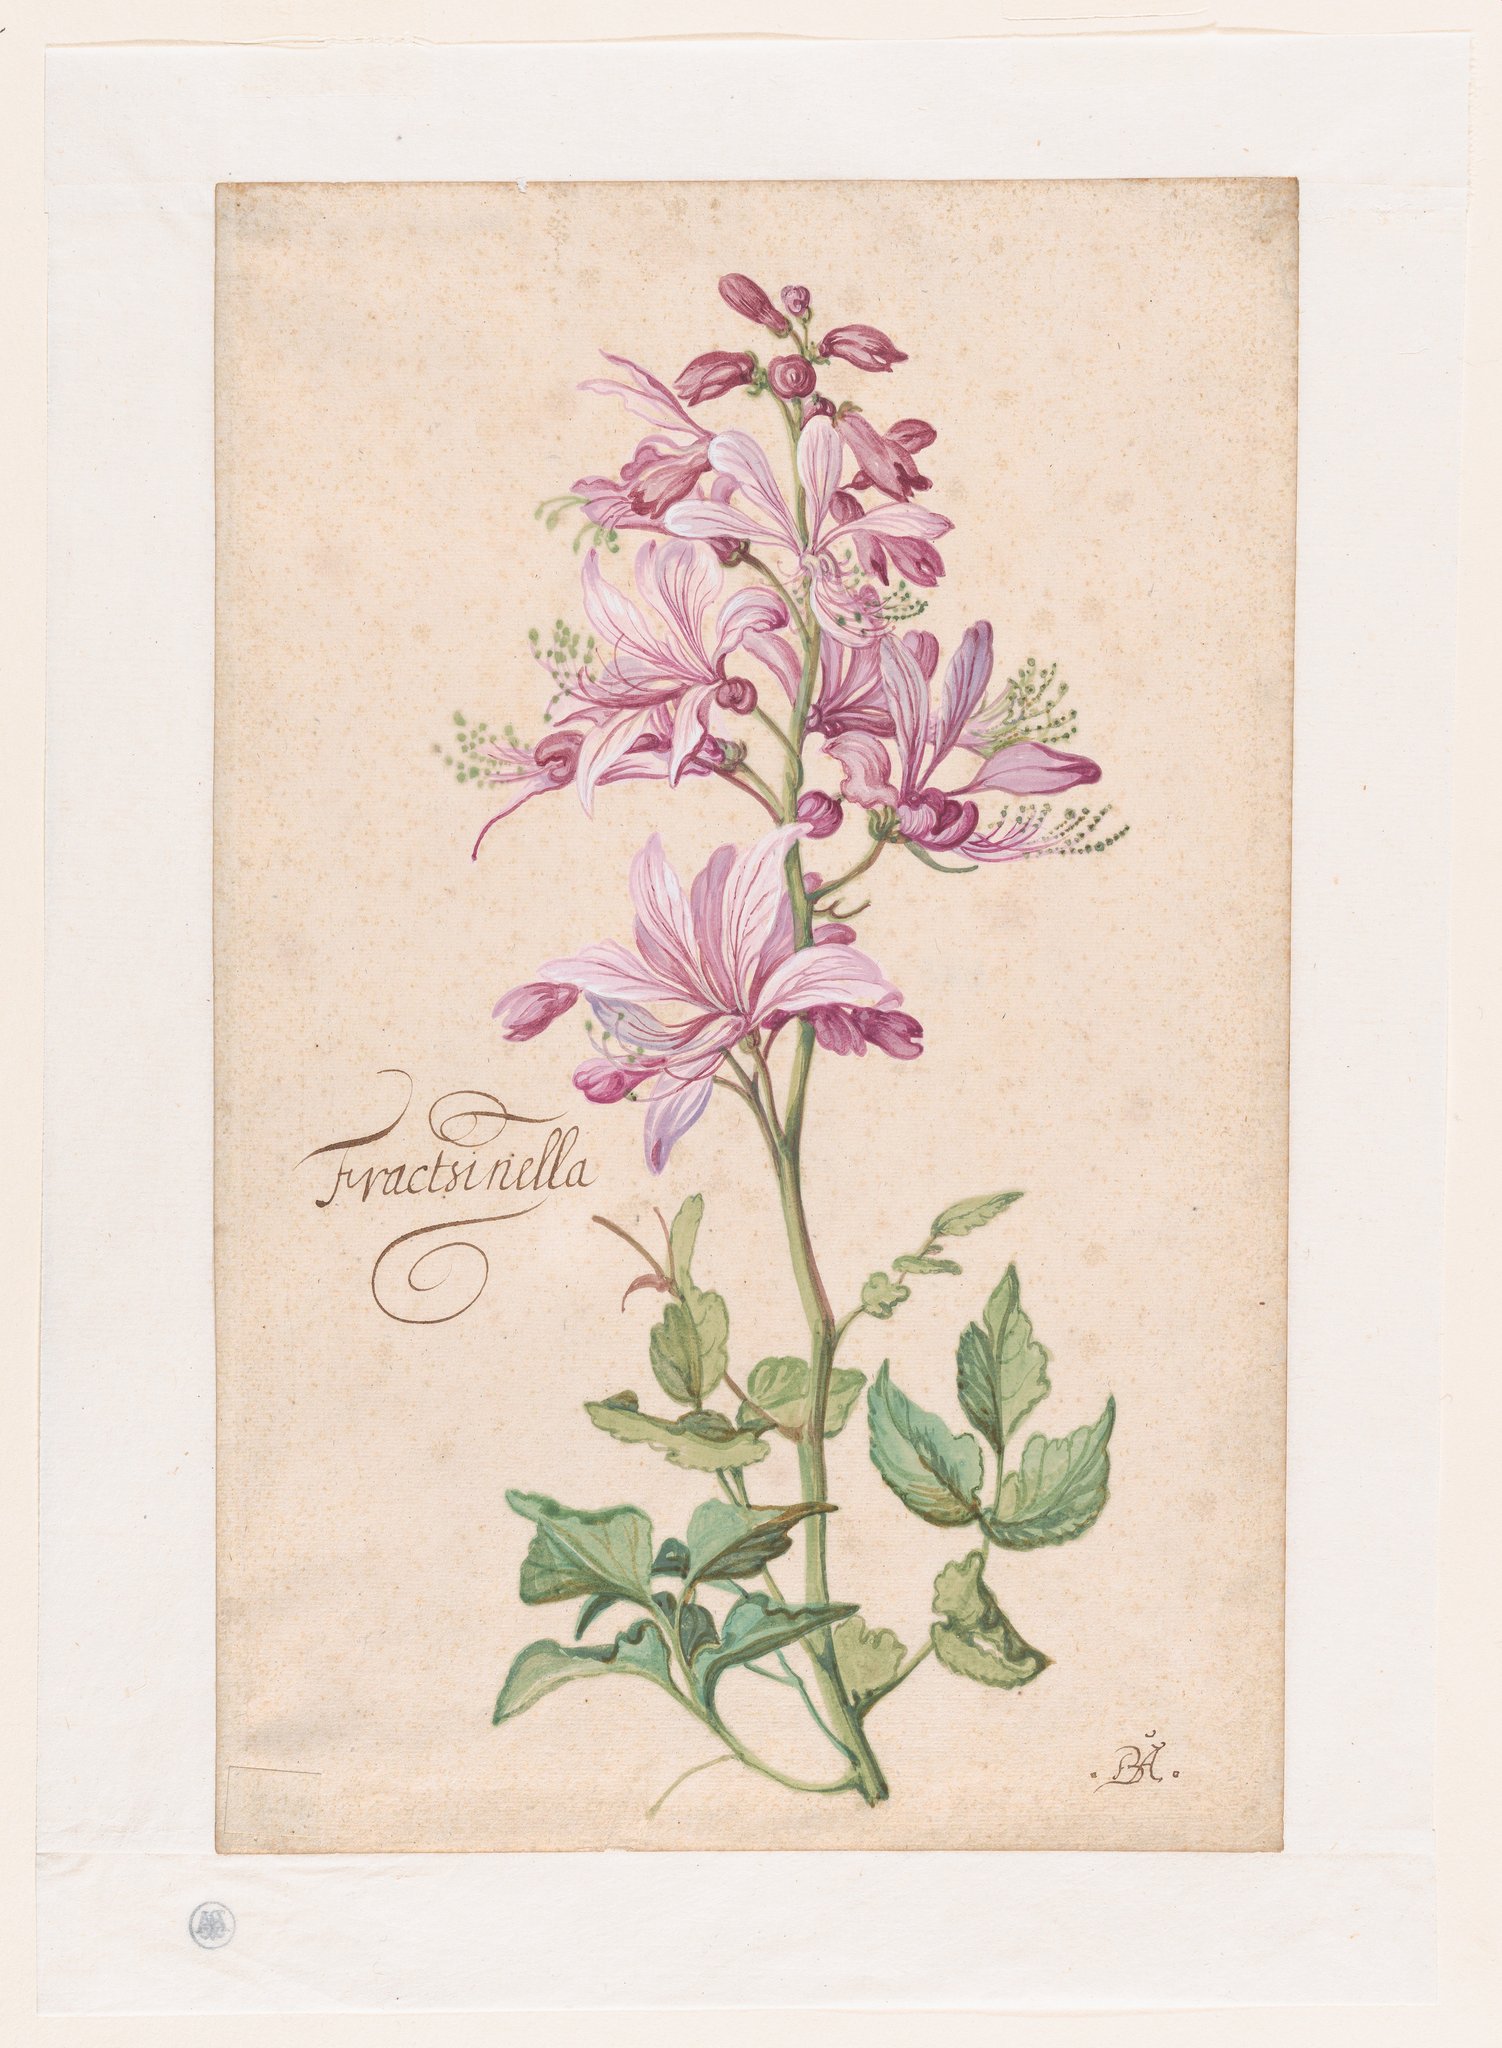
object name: drawing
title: A Dictamnus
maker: balthasar van der ast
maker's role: artist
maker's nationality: dutch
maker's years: 1593-1657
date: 1620-1630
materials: gouache, watercolor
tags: flowers,leaves